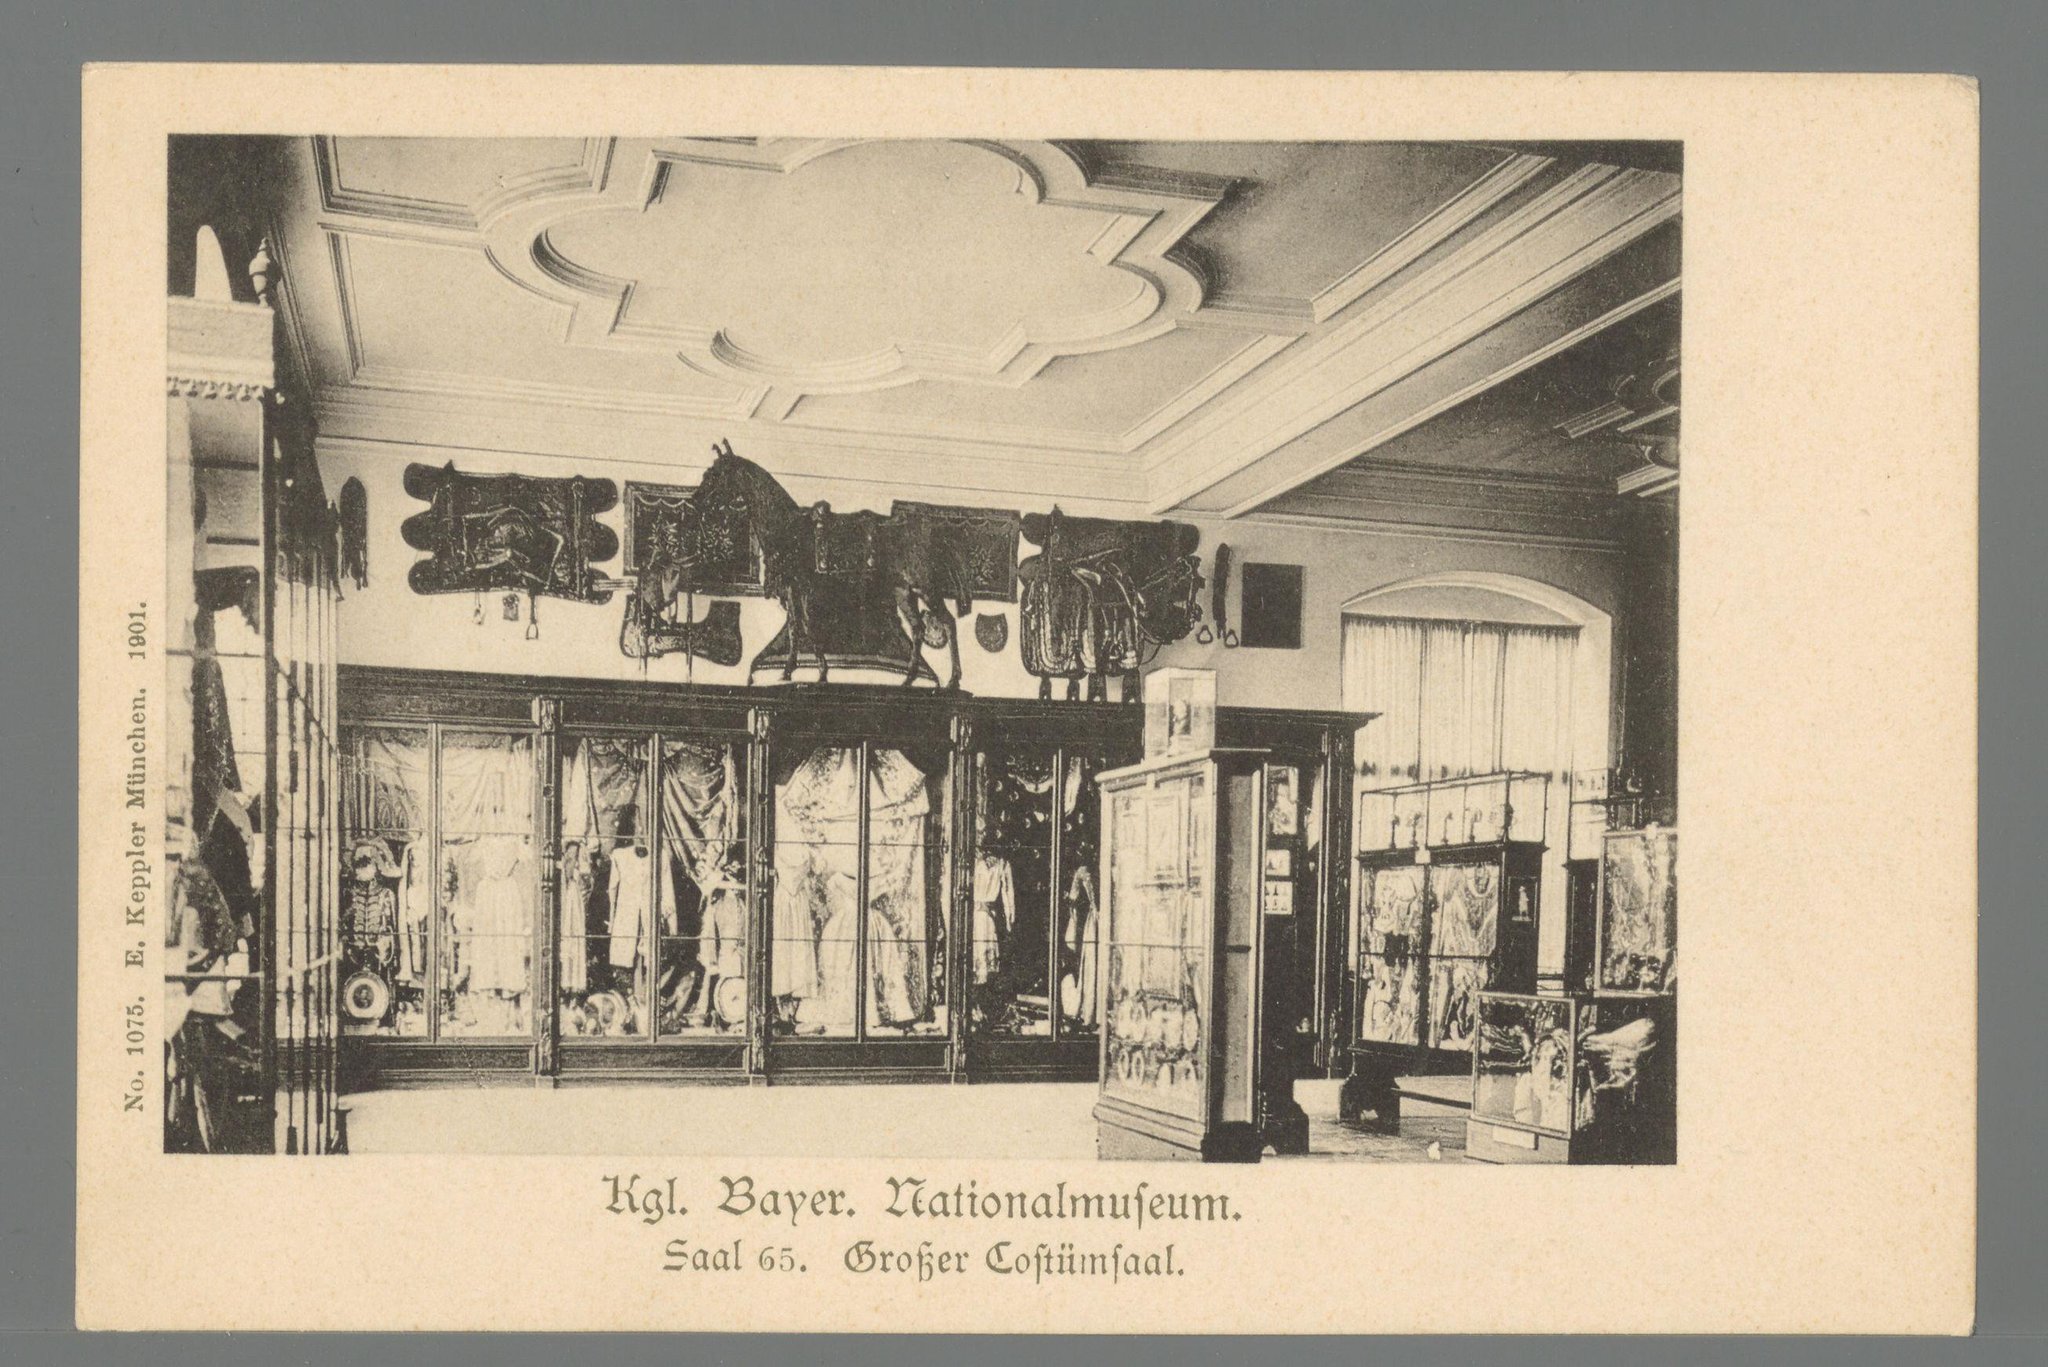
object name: ansichtkaart, prentbriefkaart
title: Kgl. Bayer. Nationalmuseum. Saal 65. Groβer Costümsaal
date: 1901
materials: cardboard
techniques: photograph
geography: munich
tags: permanent exhibition, museum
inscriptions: date